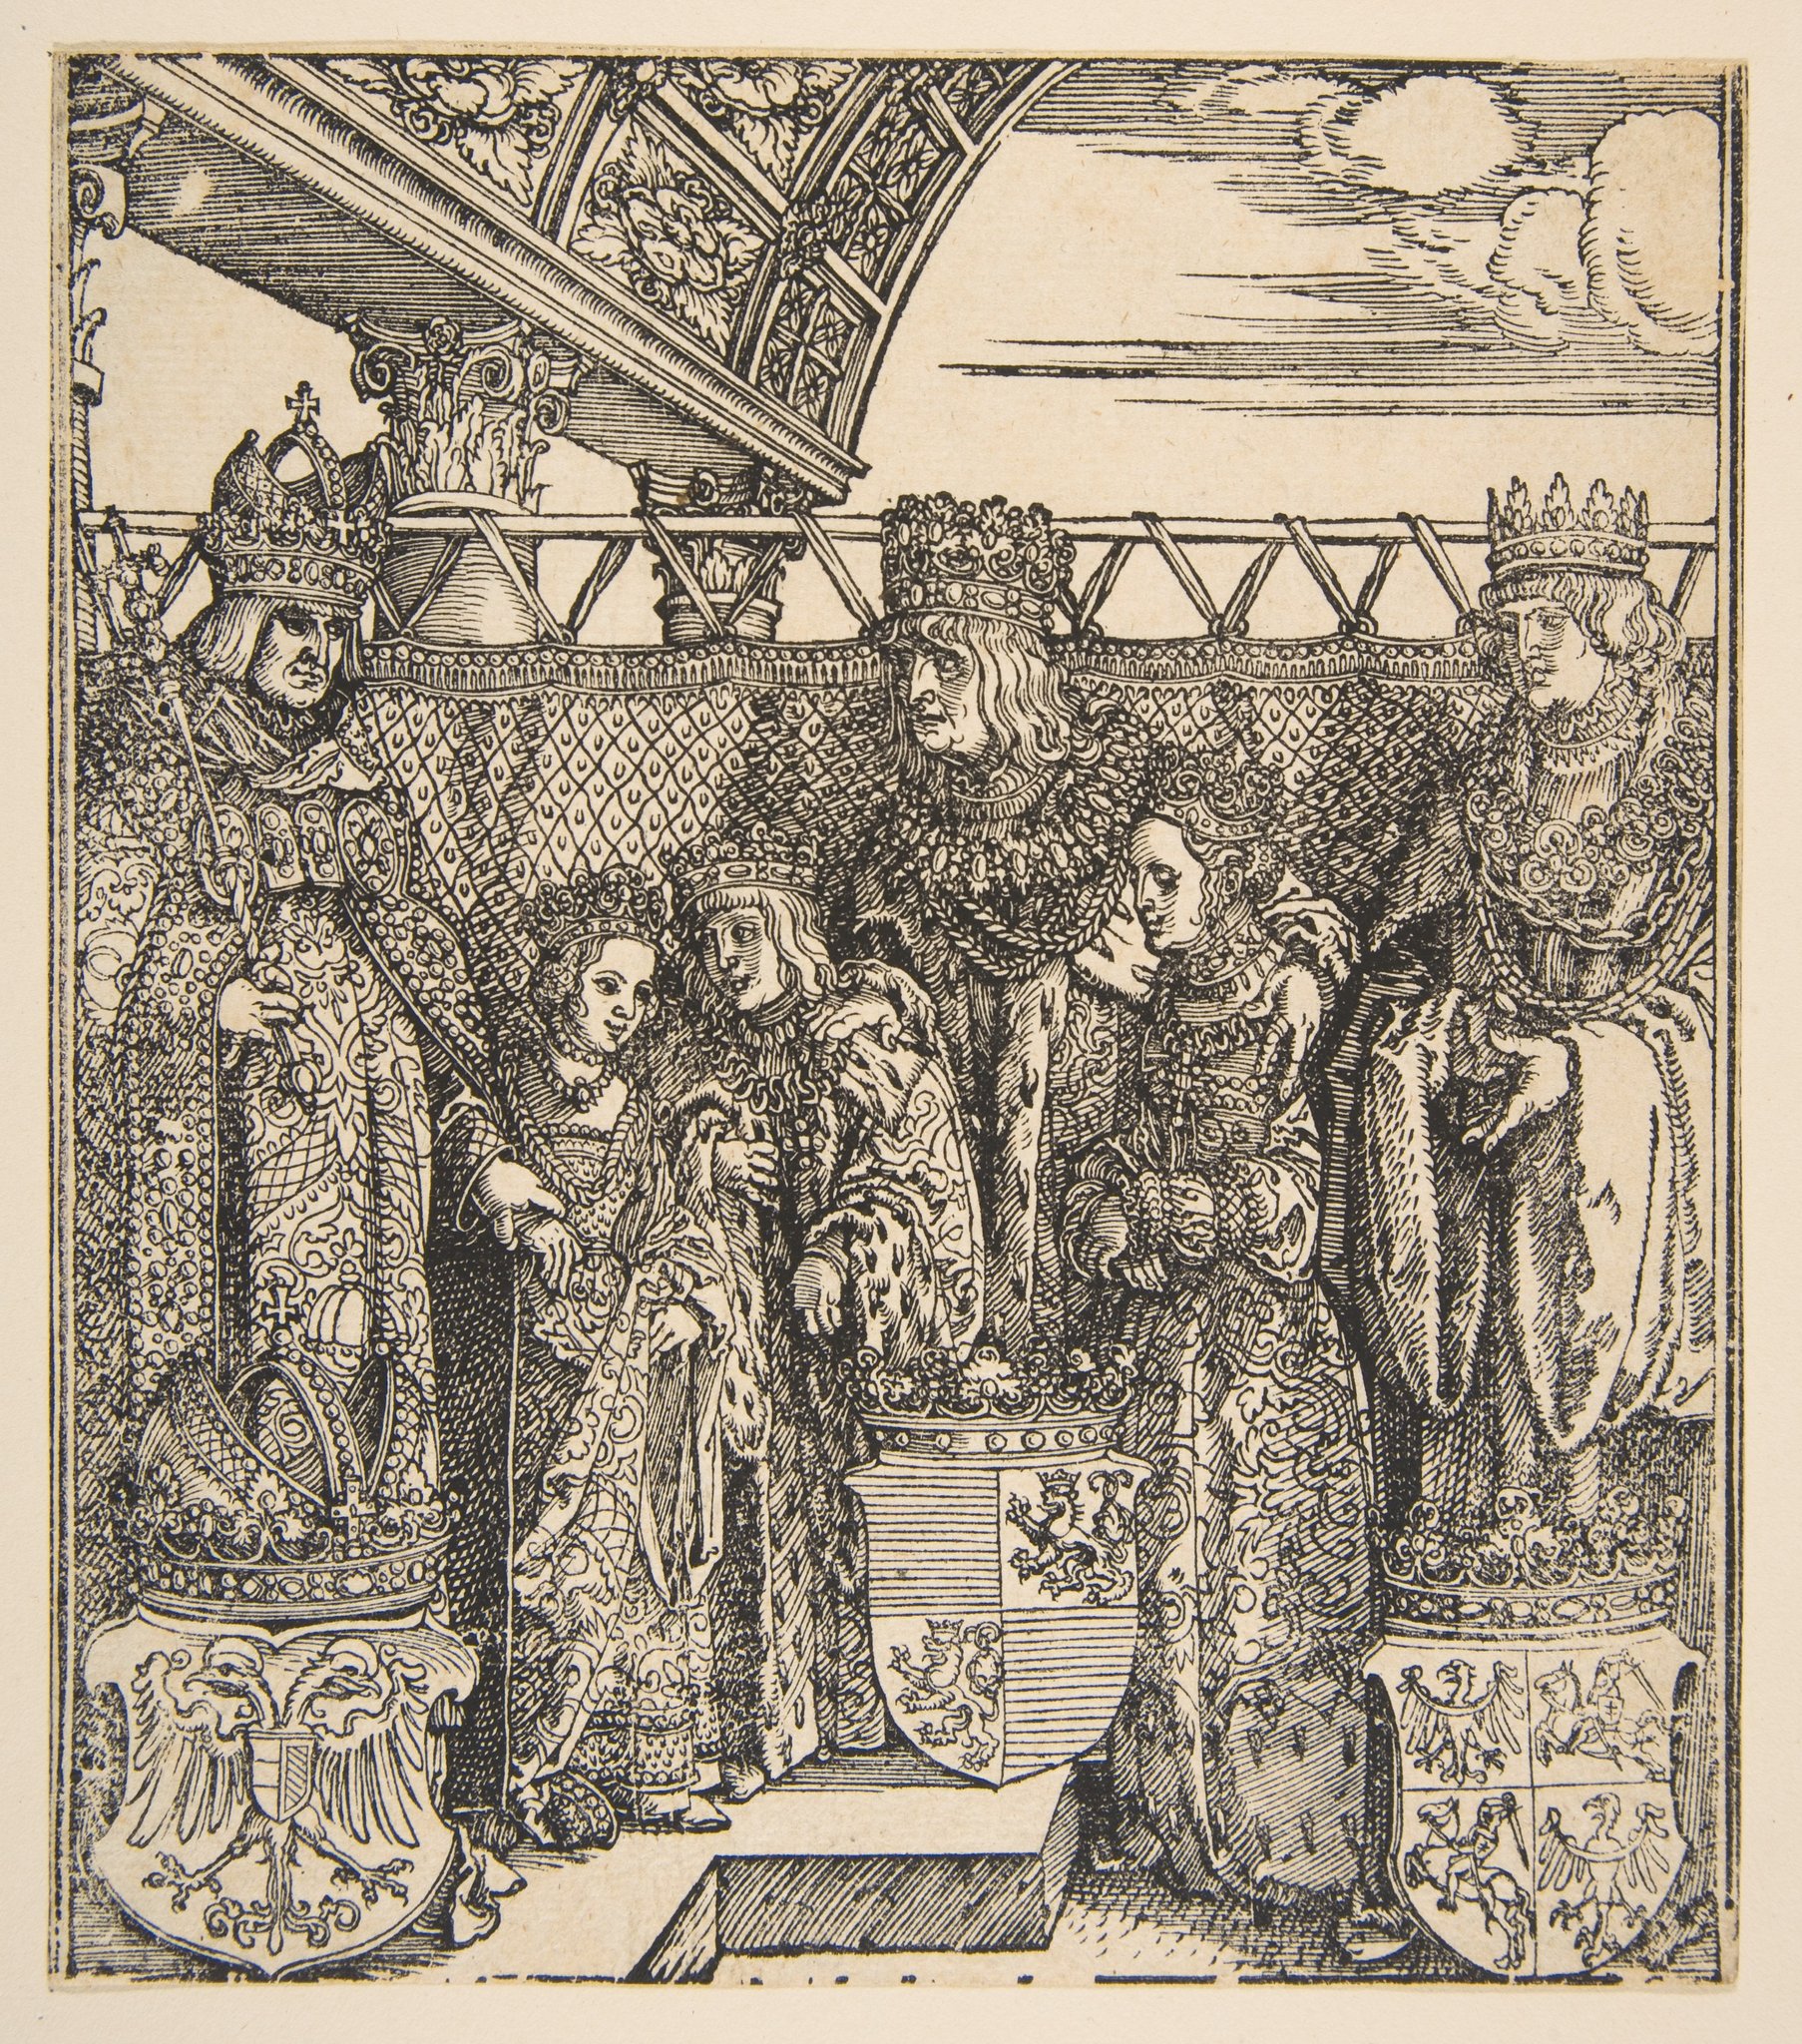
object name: print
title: The Congress of Princes at Vienna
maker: albrecht dürer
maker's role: artist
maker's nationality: german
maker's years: 1471-1528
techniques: woodcut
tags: princes,girls,men,coat of arms